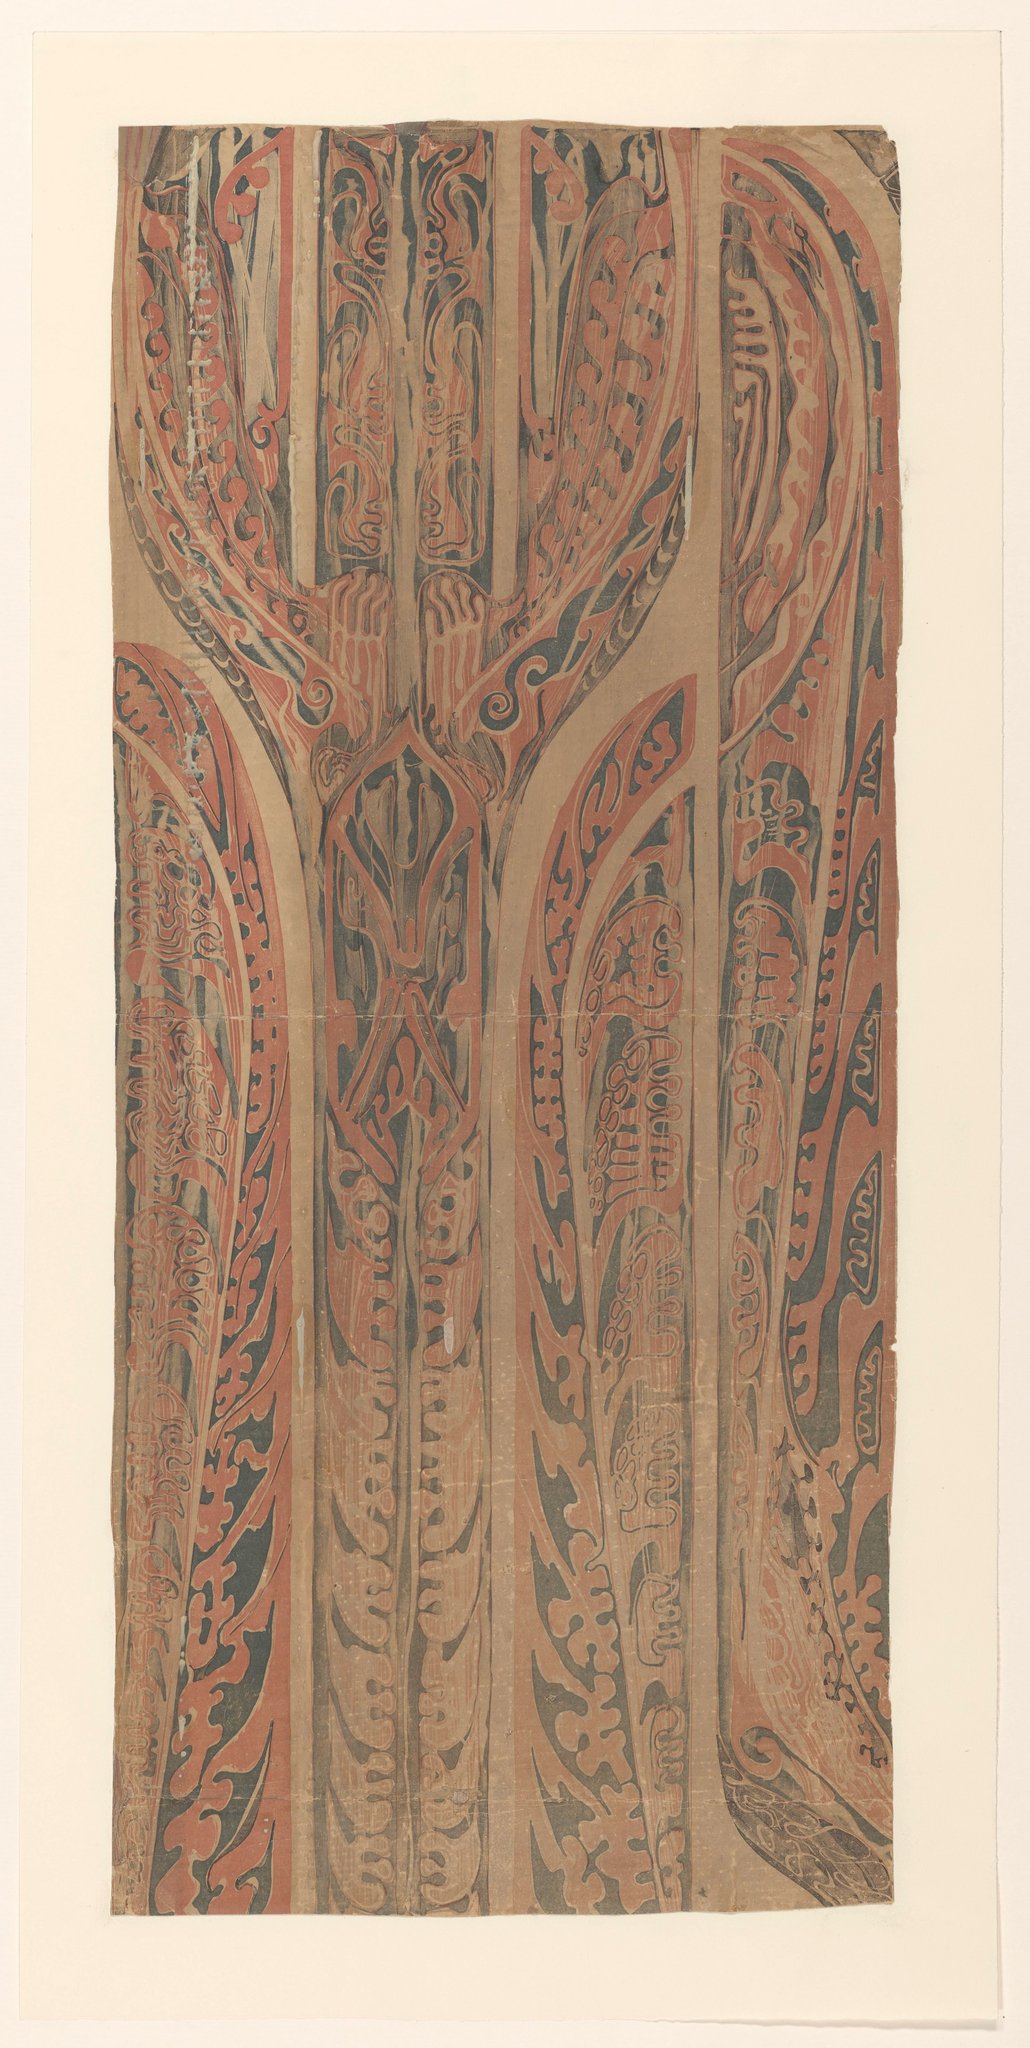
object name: print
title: Behangsel "Rode kool", 18978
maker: carel adolph lion cachet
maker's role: draughtsman, print maker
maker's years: 1864-1945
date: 1874-1945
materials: paper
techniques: lithograph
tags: ornamenting, decorating ~ applied arts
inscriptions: collector's mark: Lugt 2228